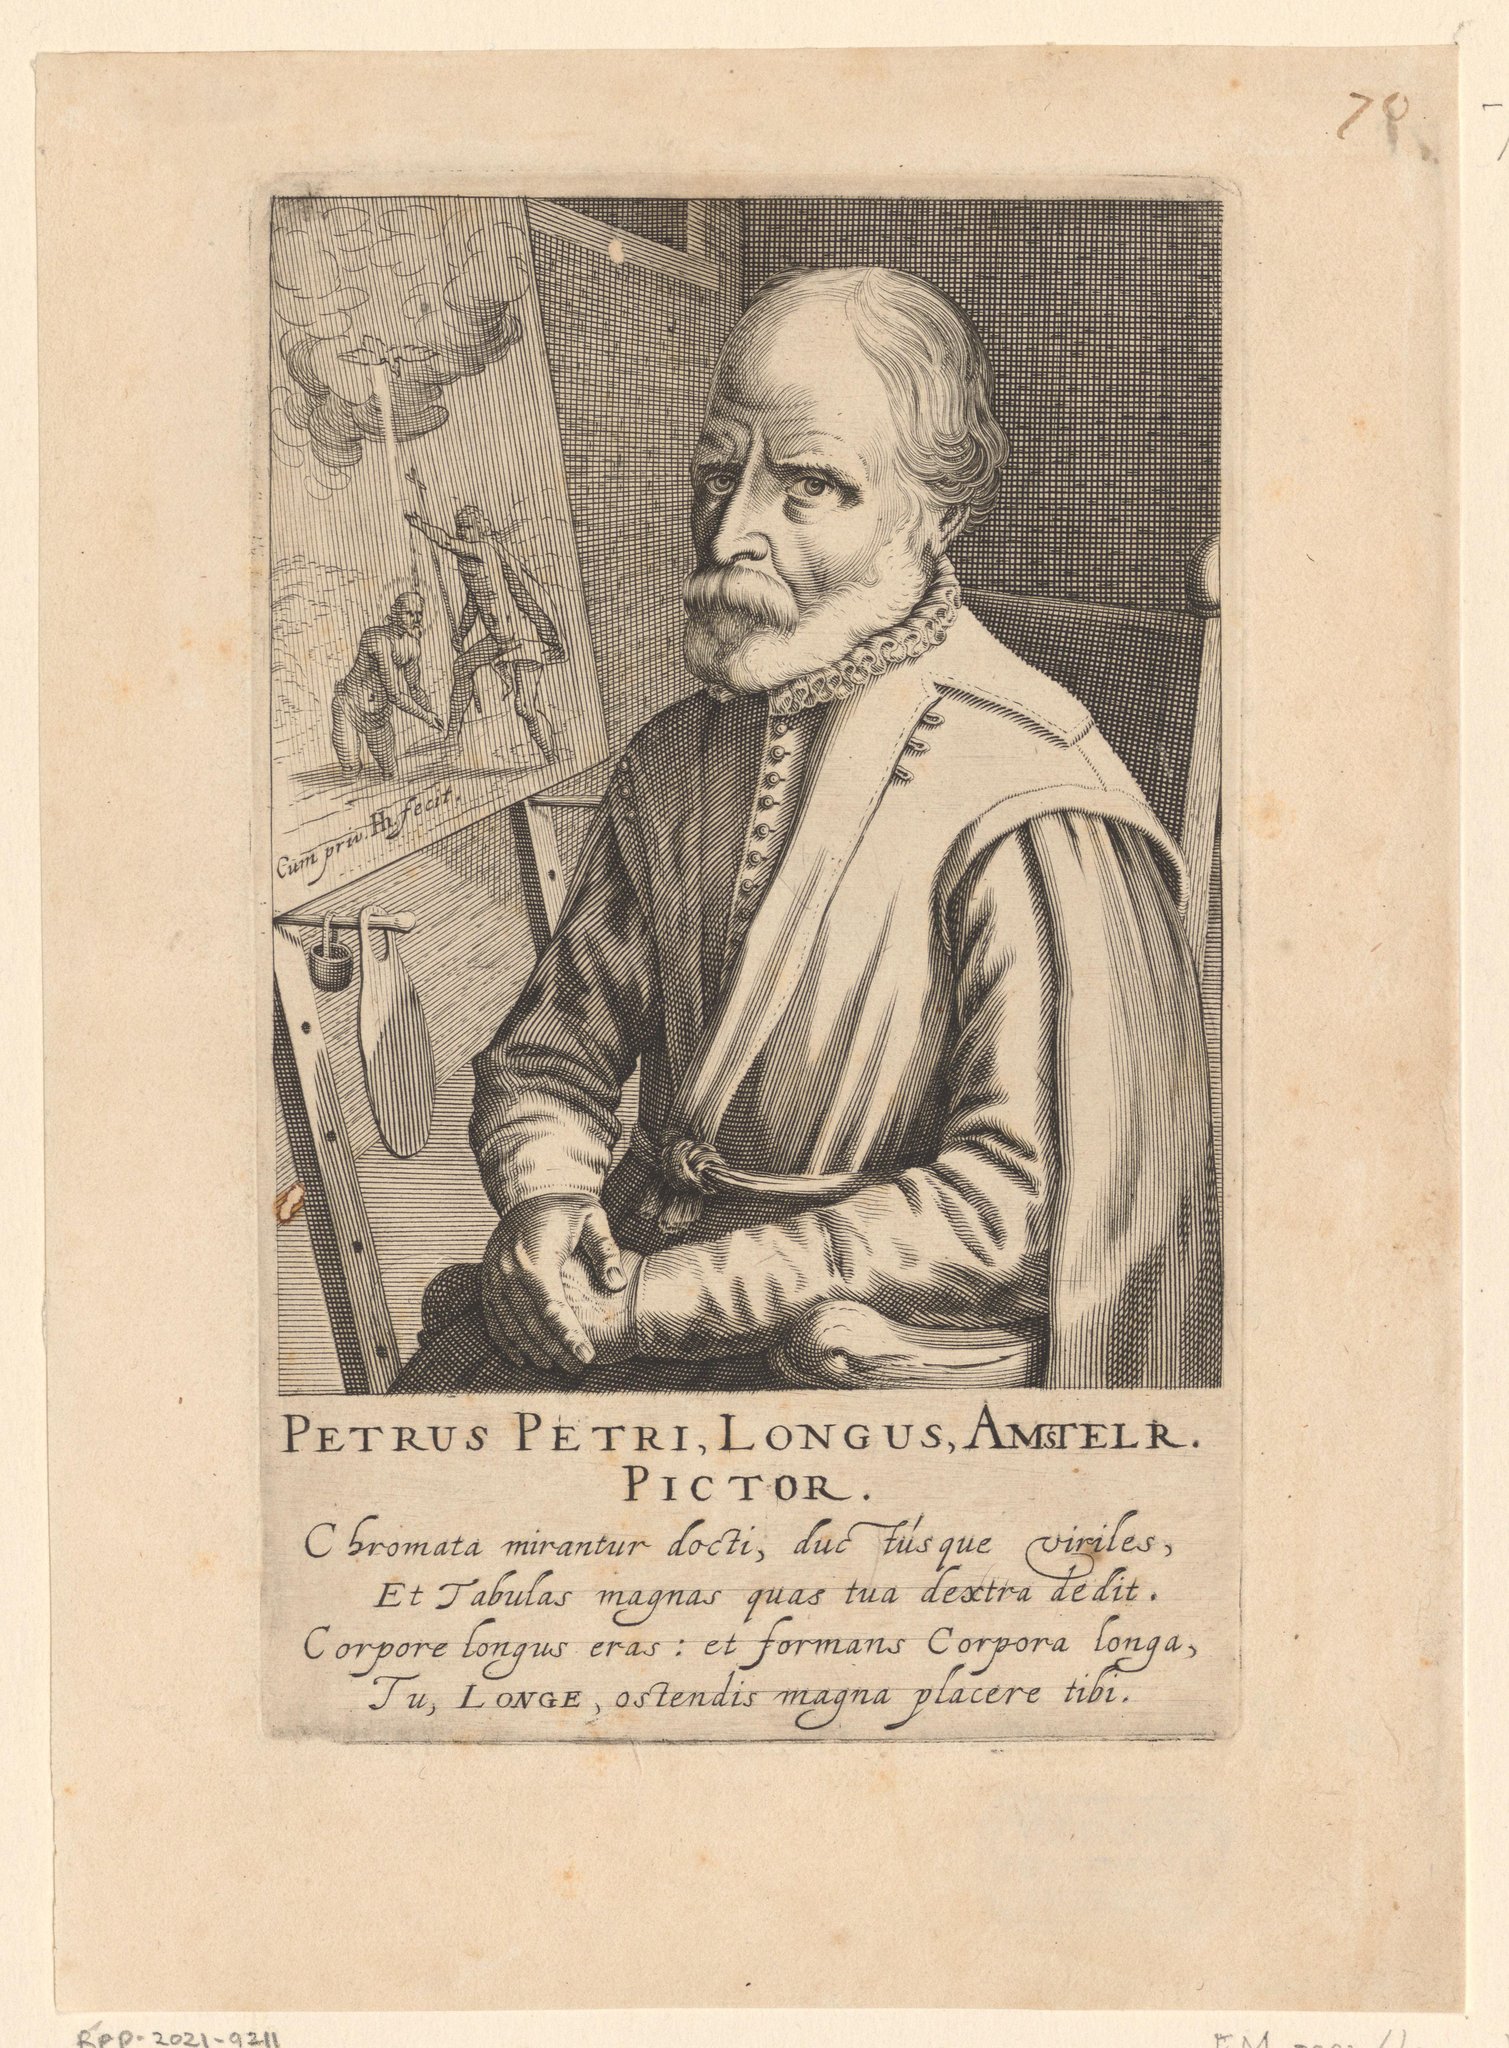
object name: print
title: Pictorum aliquot celebrium praecipuae Germaniae Inferioris effigies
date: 1610-1618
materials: paper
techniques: engraving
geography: the hague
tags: antwerp, painter, pieter pietersz. (i), historical persons, portrait, self-portrait of painter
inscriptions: collector's mark: Lugt 11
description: Prent behoort tot het tweede deel van de serie 'Pictorum Aliquot Celebrium Praecipuae Germaniae Inferioris Effigies'. Deze serie bestaat uit 72 kunstenaarsportretten vervaardigd door Hendrick Hondius I, Simon Frisius, Andries Jacobsz. Stock en Robert de Baudous. Of mogelijk onderdeel van de serie 'Theatrum honoris in quo nostri apelles' (1618). Of prent mogelijk uit: Mander, Karel van. Het Schilder Boeck Waerin Voor Eerst de Leerlustige Ieught Den Gront Der Edel Vrye Schilderkonst in Verscheyden Deelen Wort Voor-gedragen. Amsterdam: Jacob Pieter Wacher, 1618. Eerder geïdentificeerd als Pieter Aertsen.